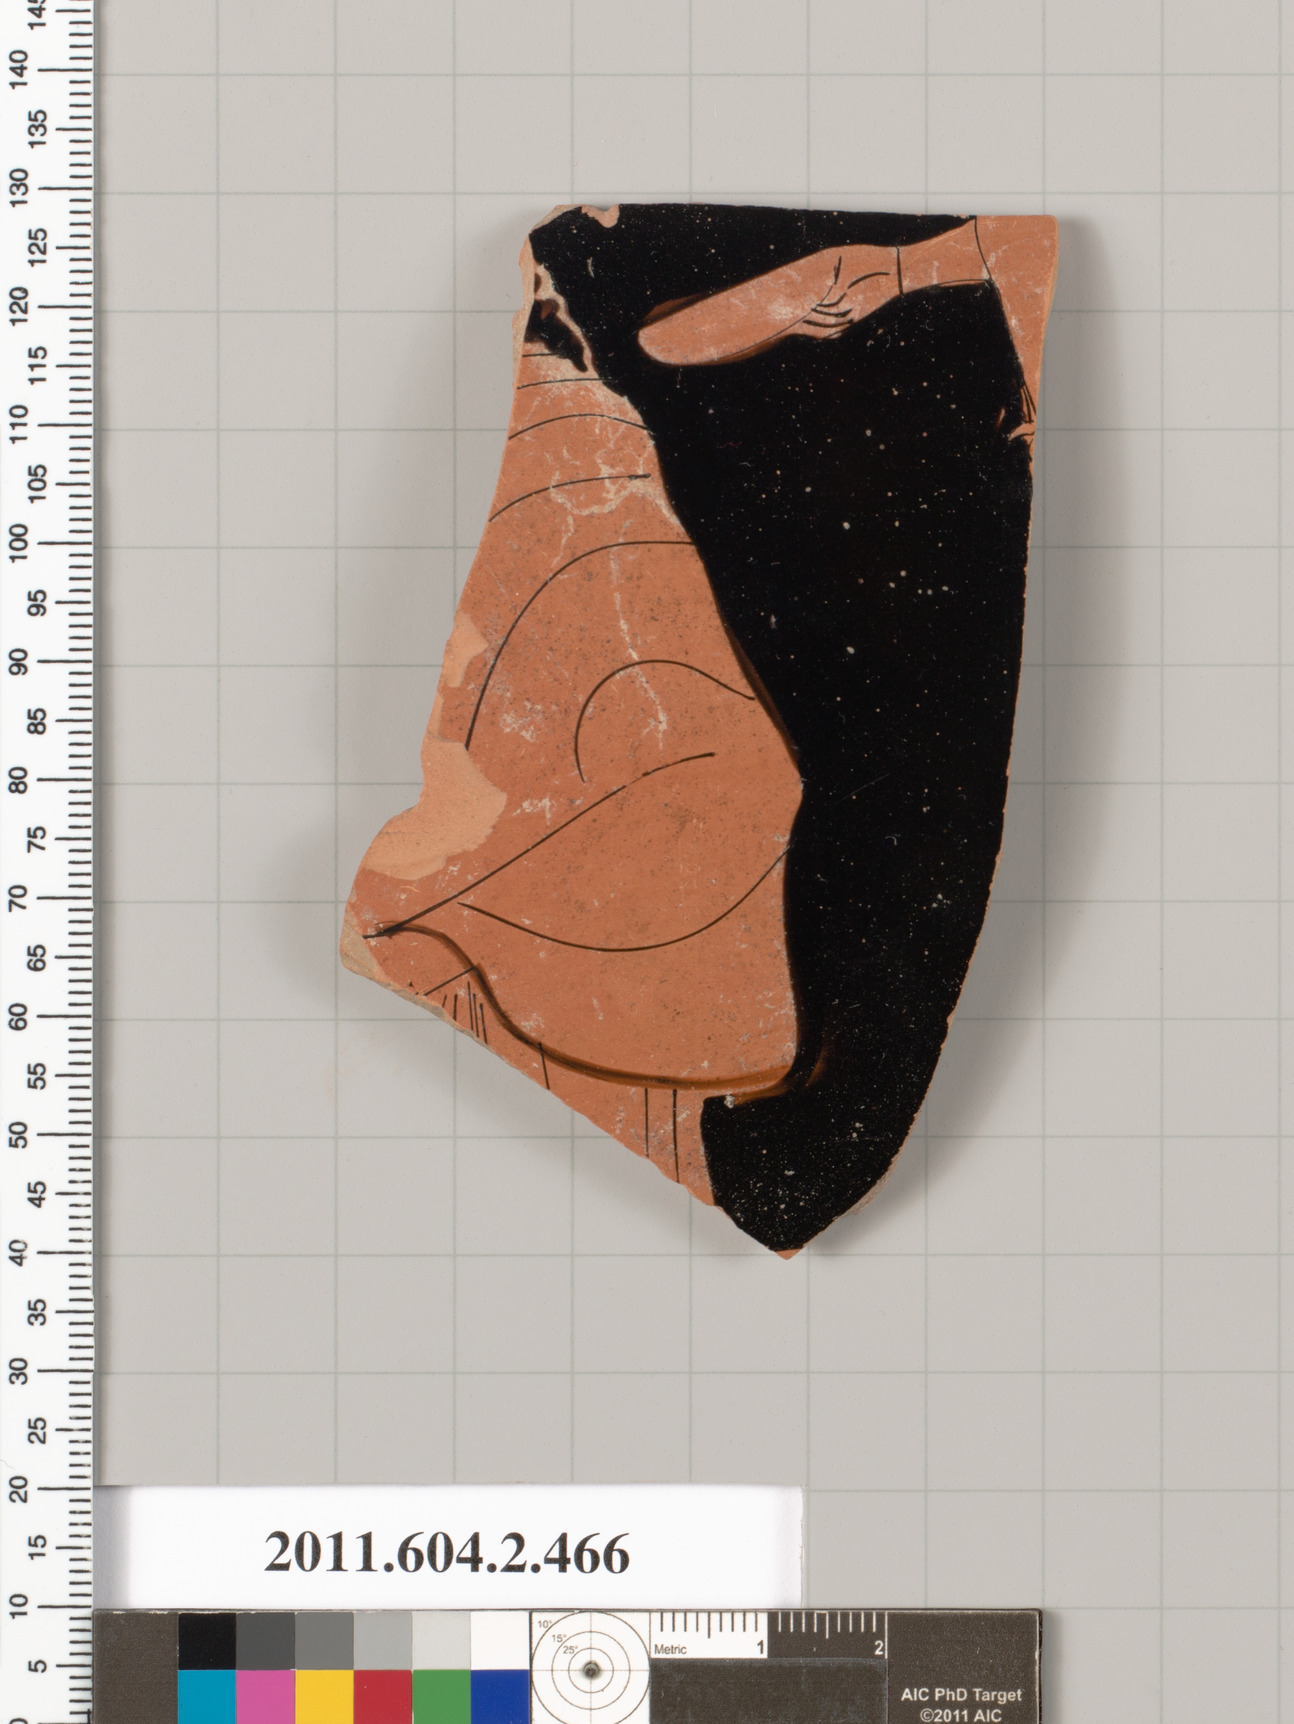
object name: column krater fragment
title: Terracotta fragment of a column-krater (bowl for mixing wine and water)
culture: greek, attic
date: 467-435 BCE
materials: terracotta